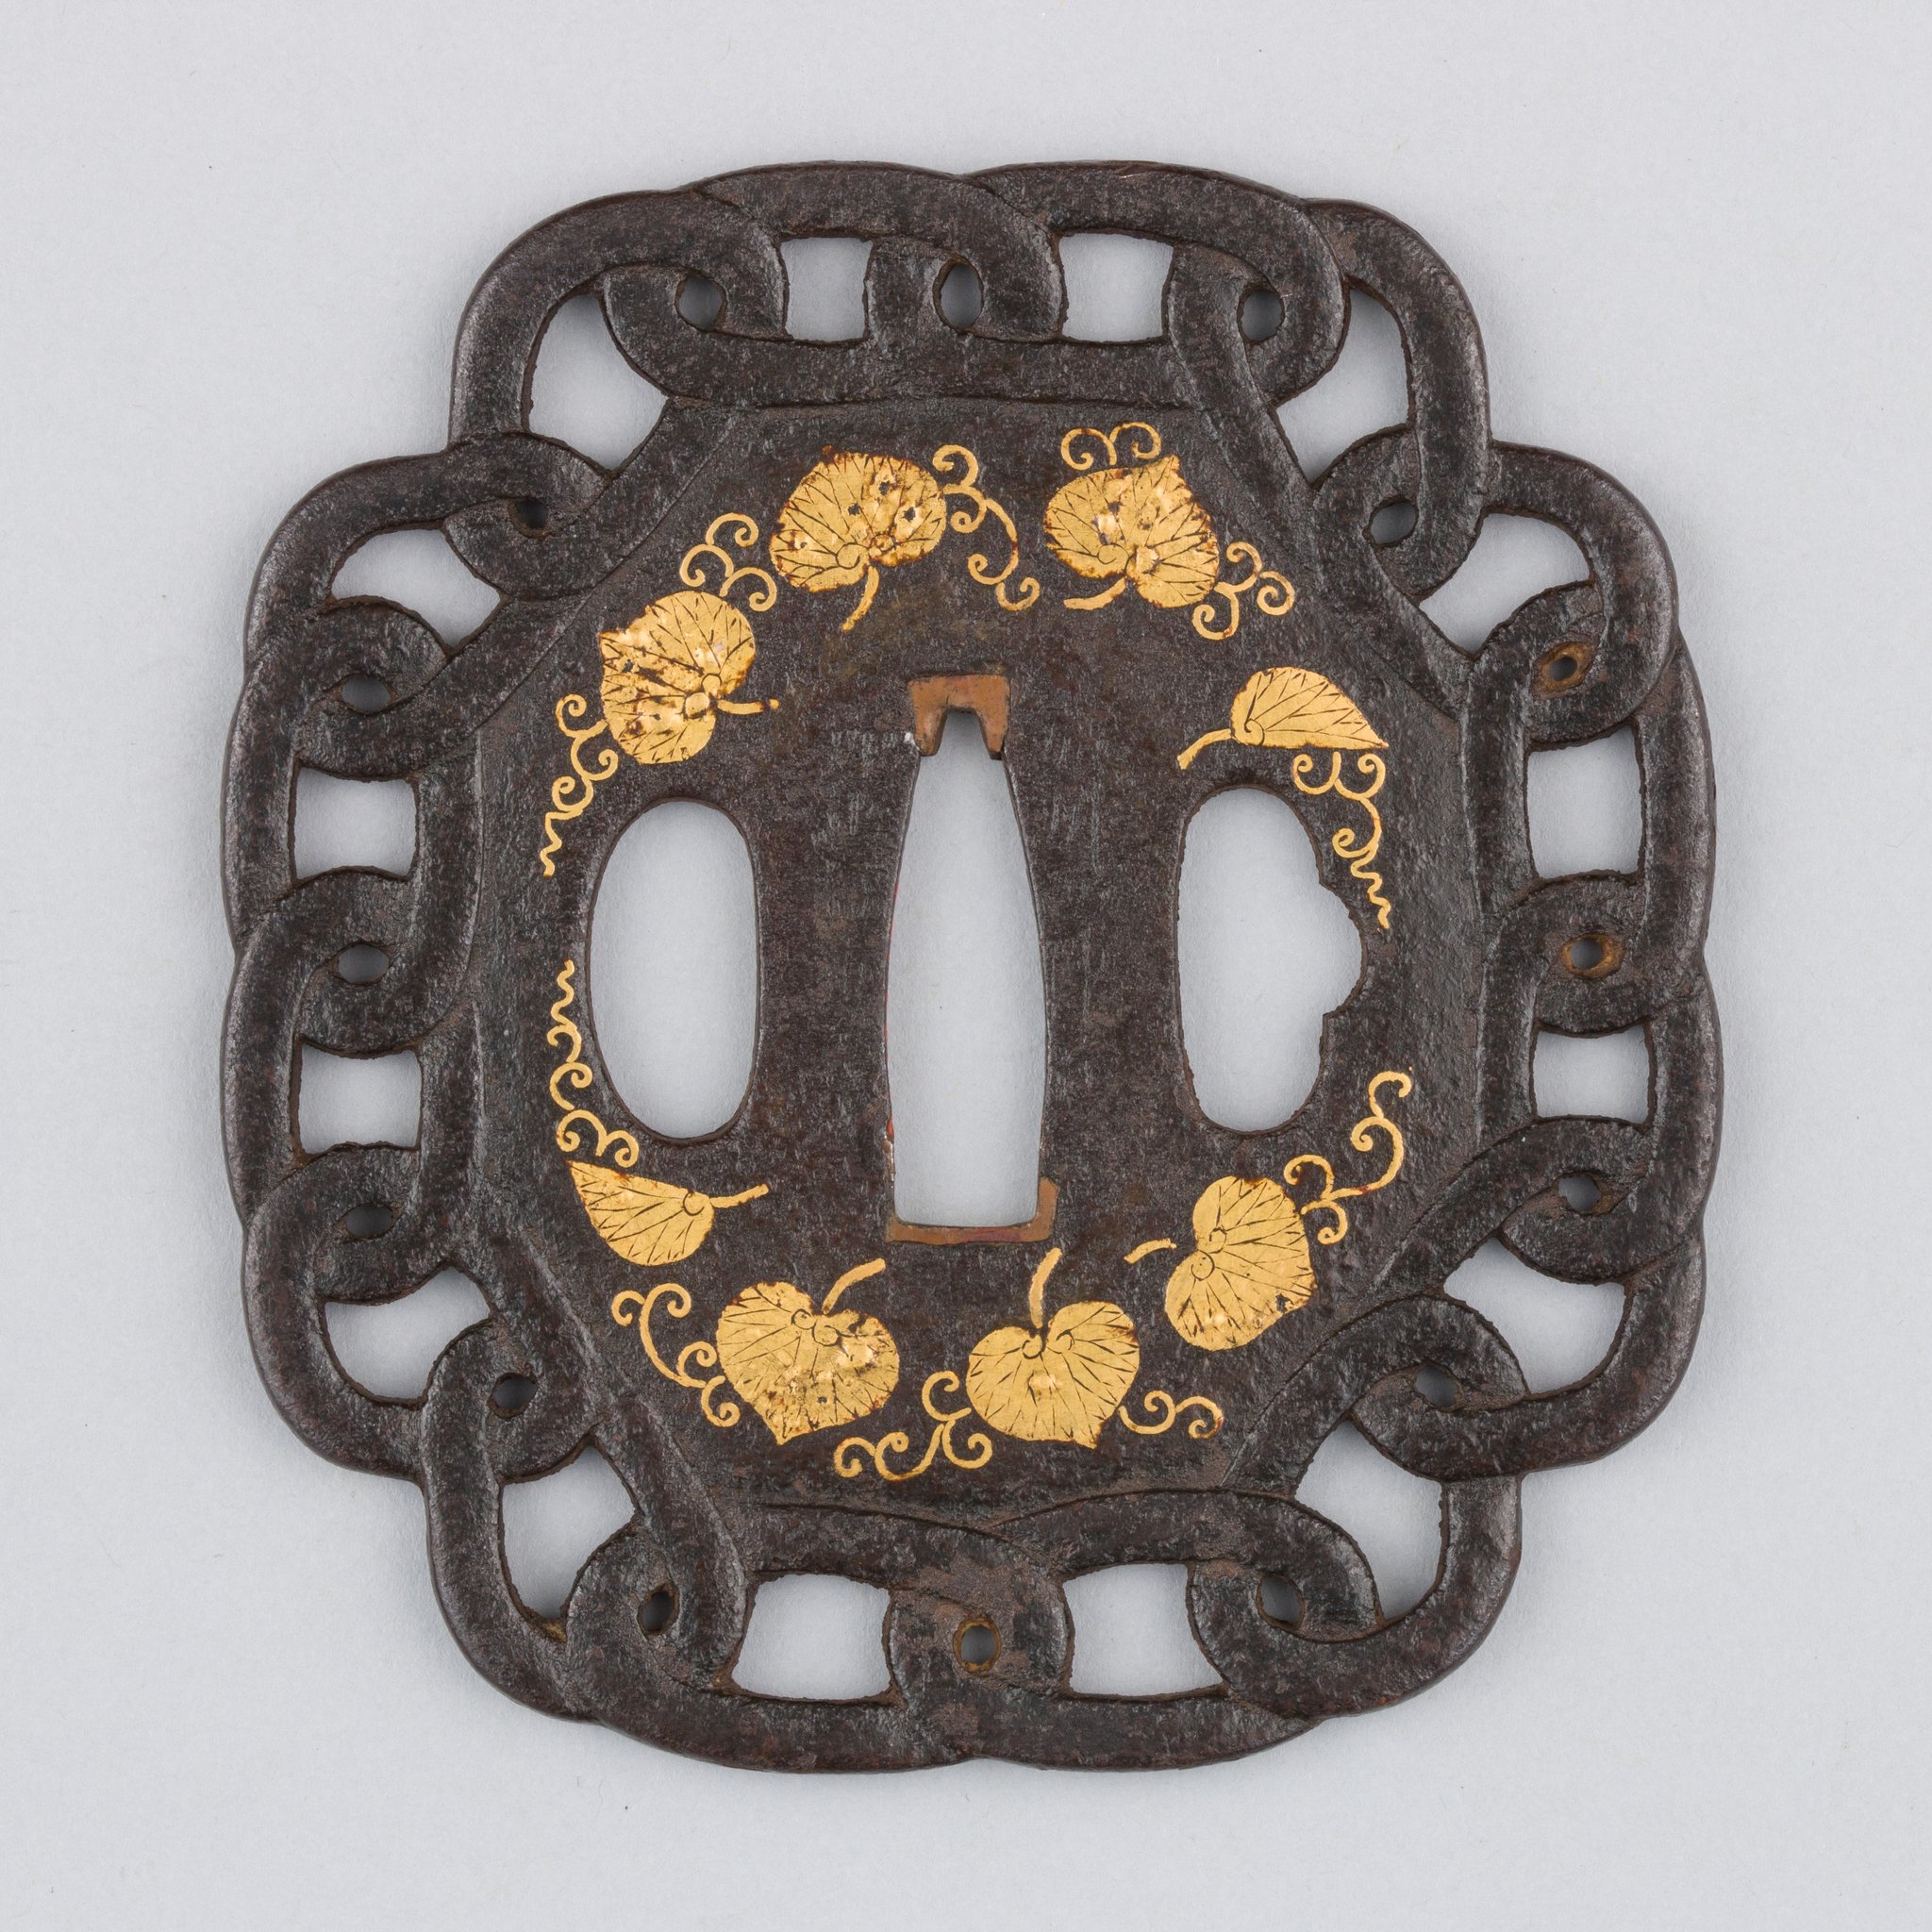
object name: sword guard tsuba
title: Sword Guard (Tsuba)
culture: japanese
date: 1601-1700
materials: copper, gold, iron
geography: japan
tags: leaves